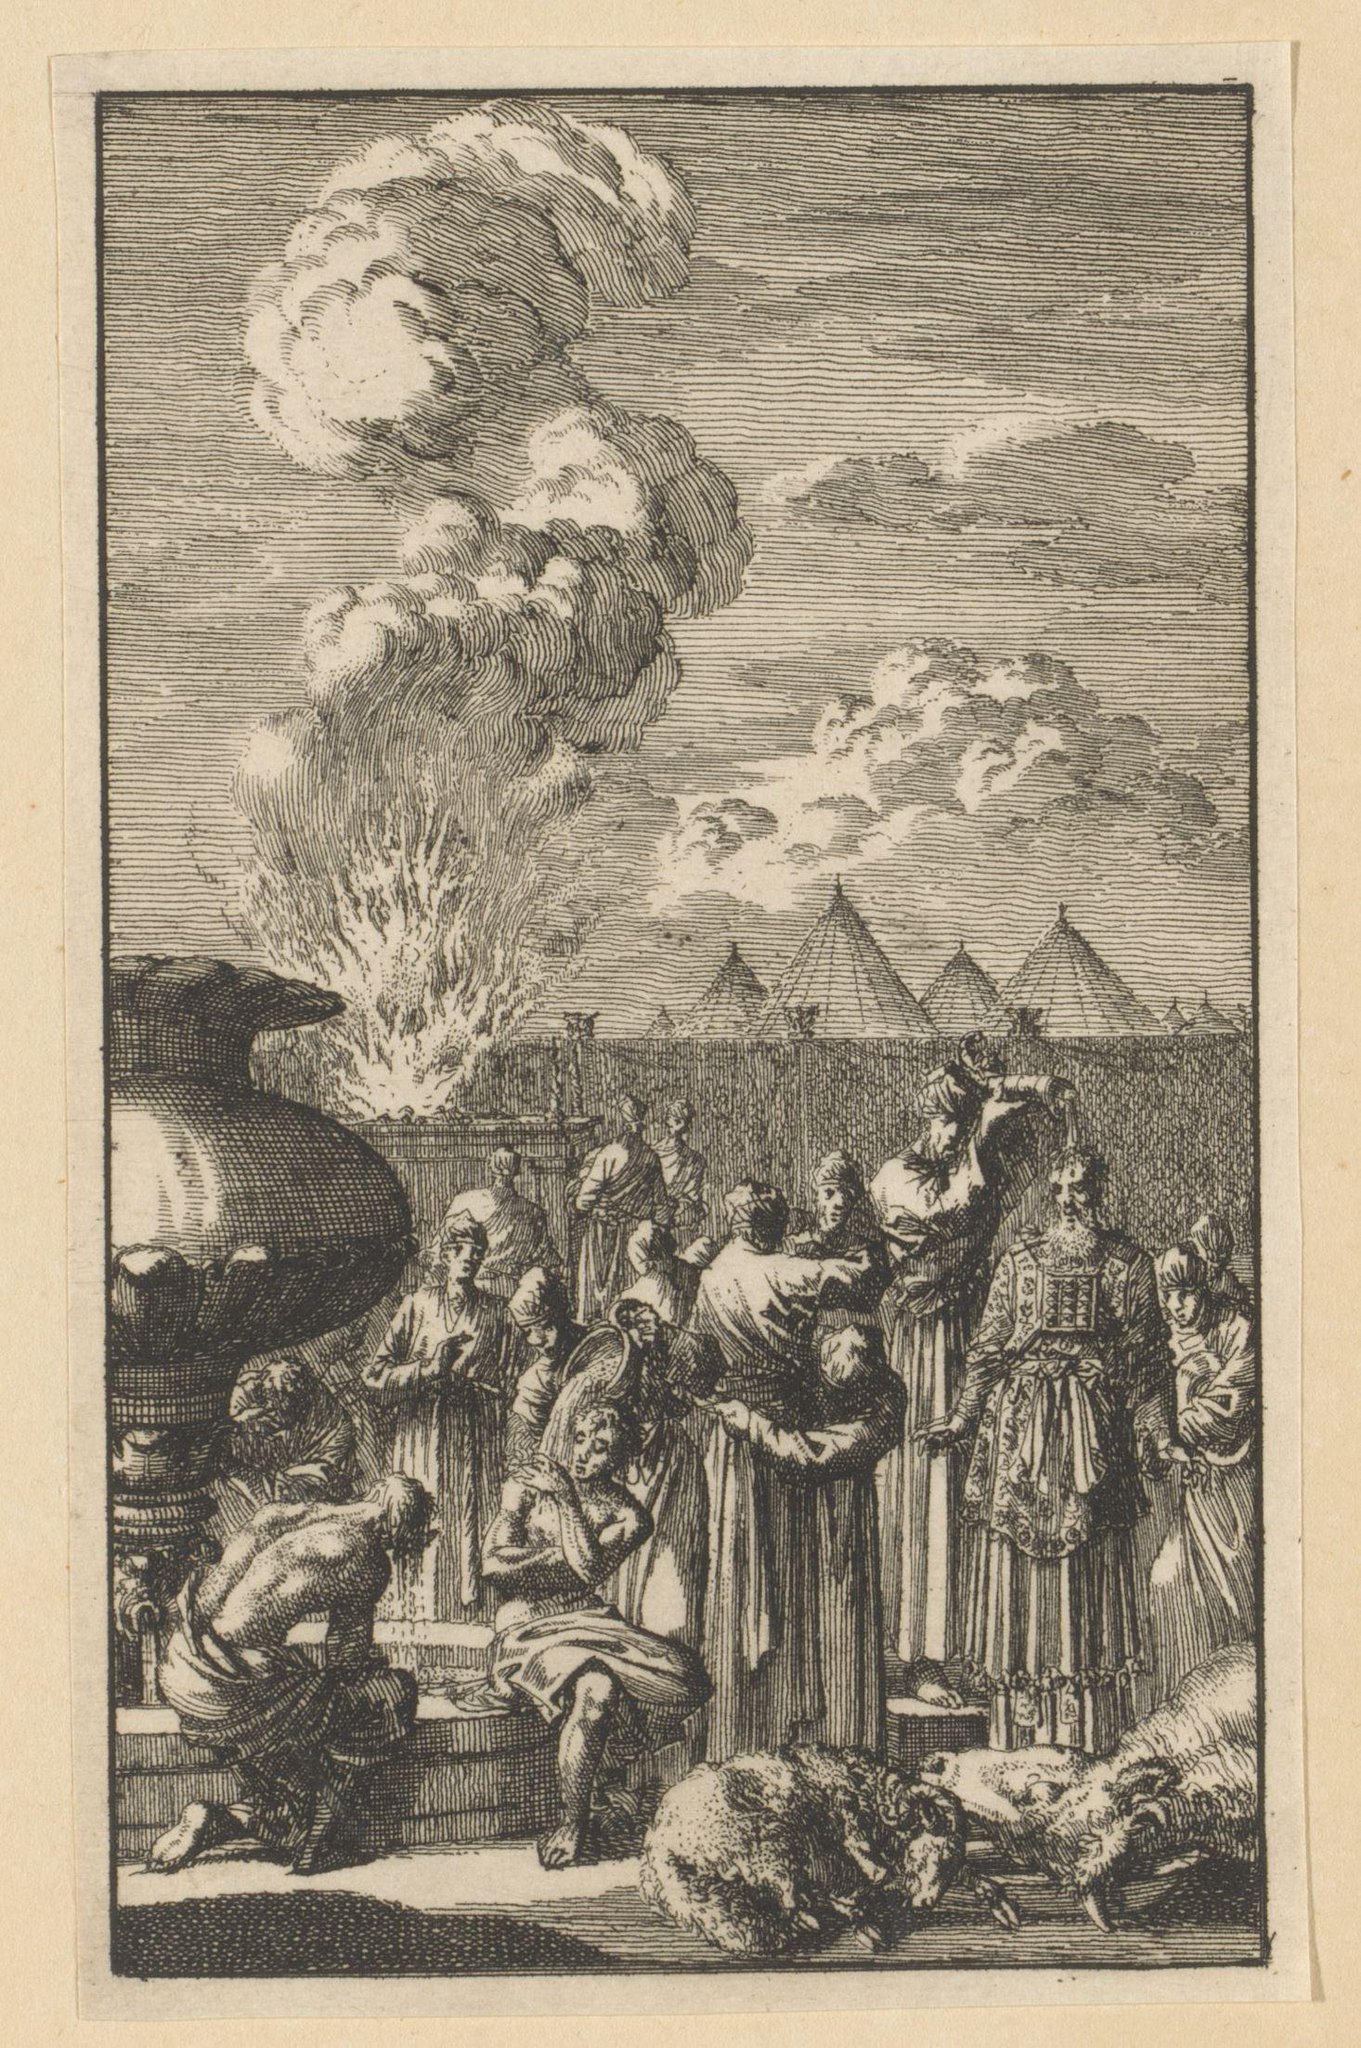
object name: print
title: Hogepriester wordt gezalfd bij altaar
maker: jan luyken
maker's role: draughtsman, print maker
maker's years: 1649-1712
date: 1659-1712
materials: paper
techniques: etching